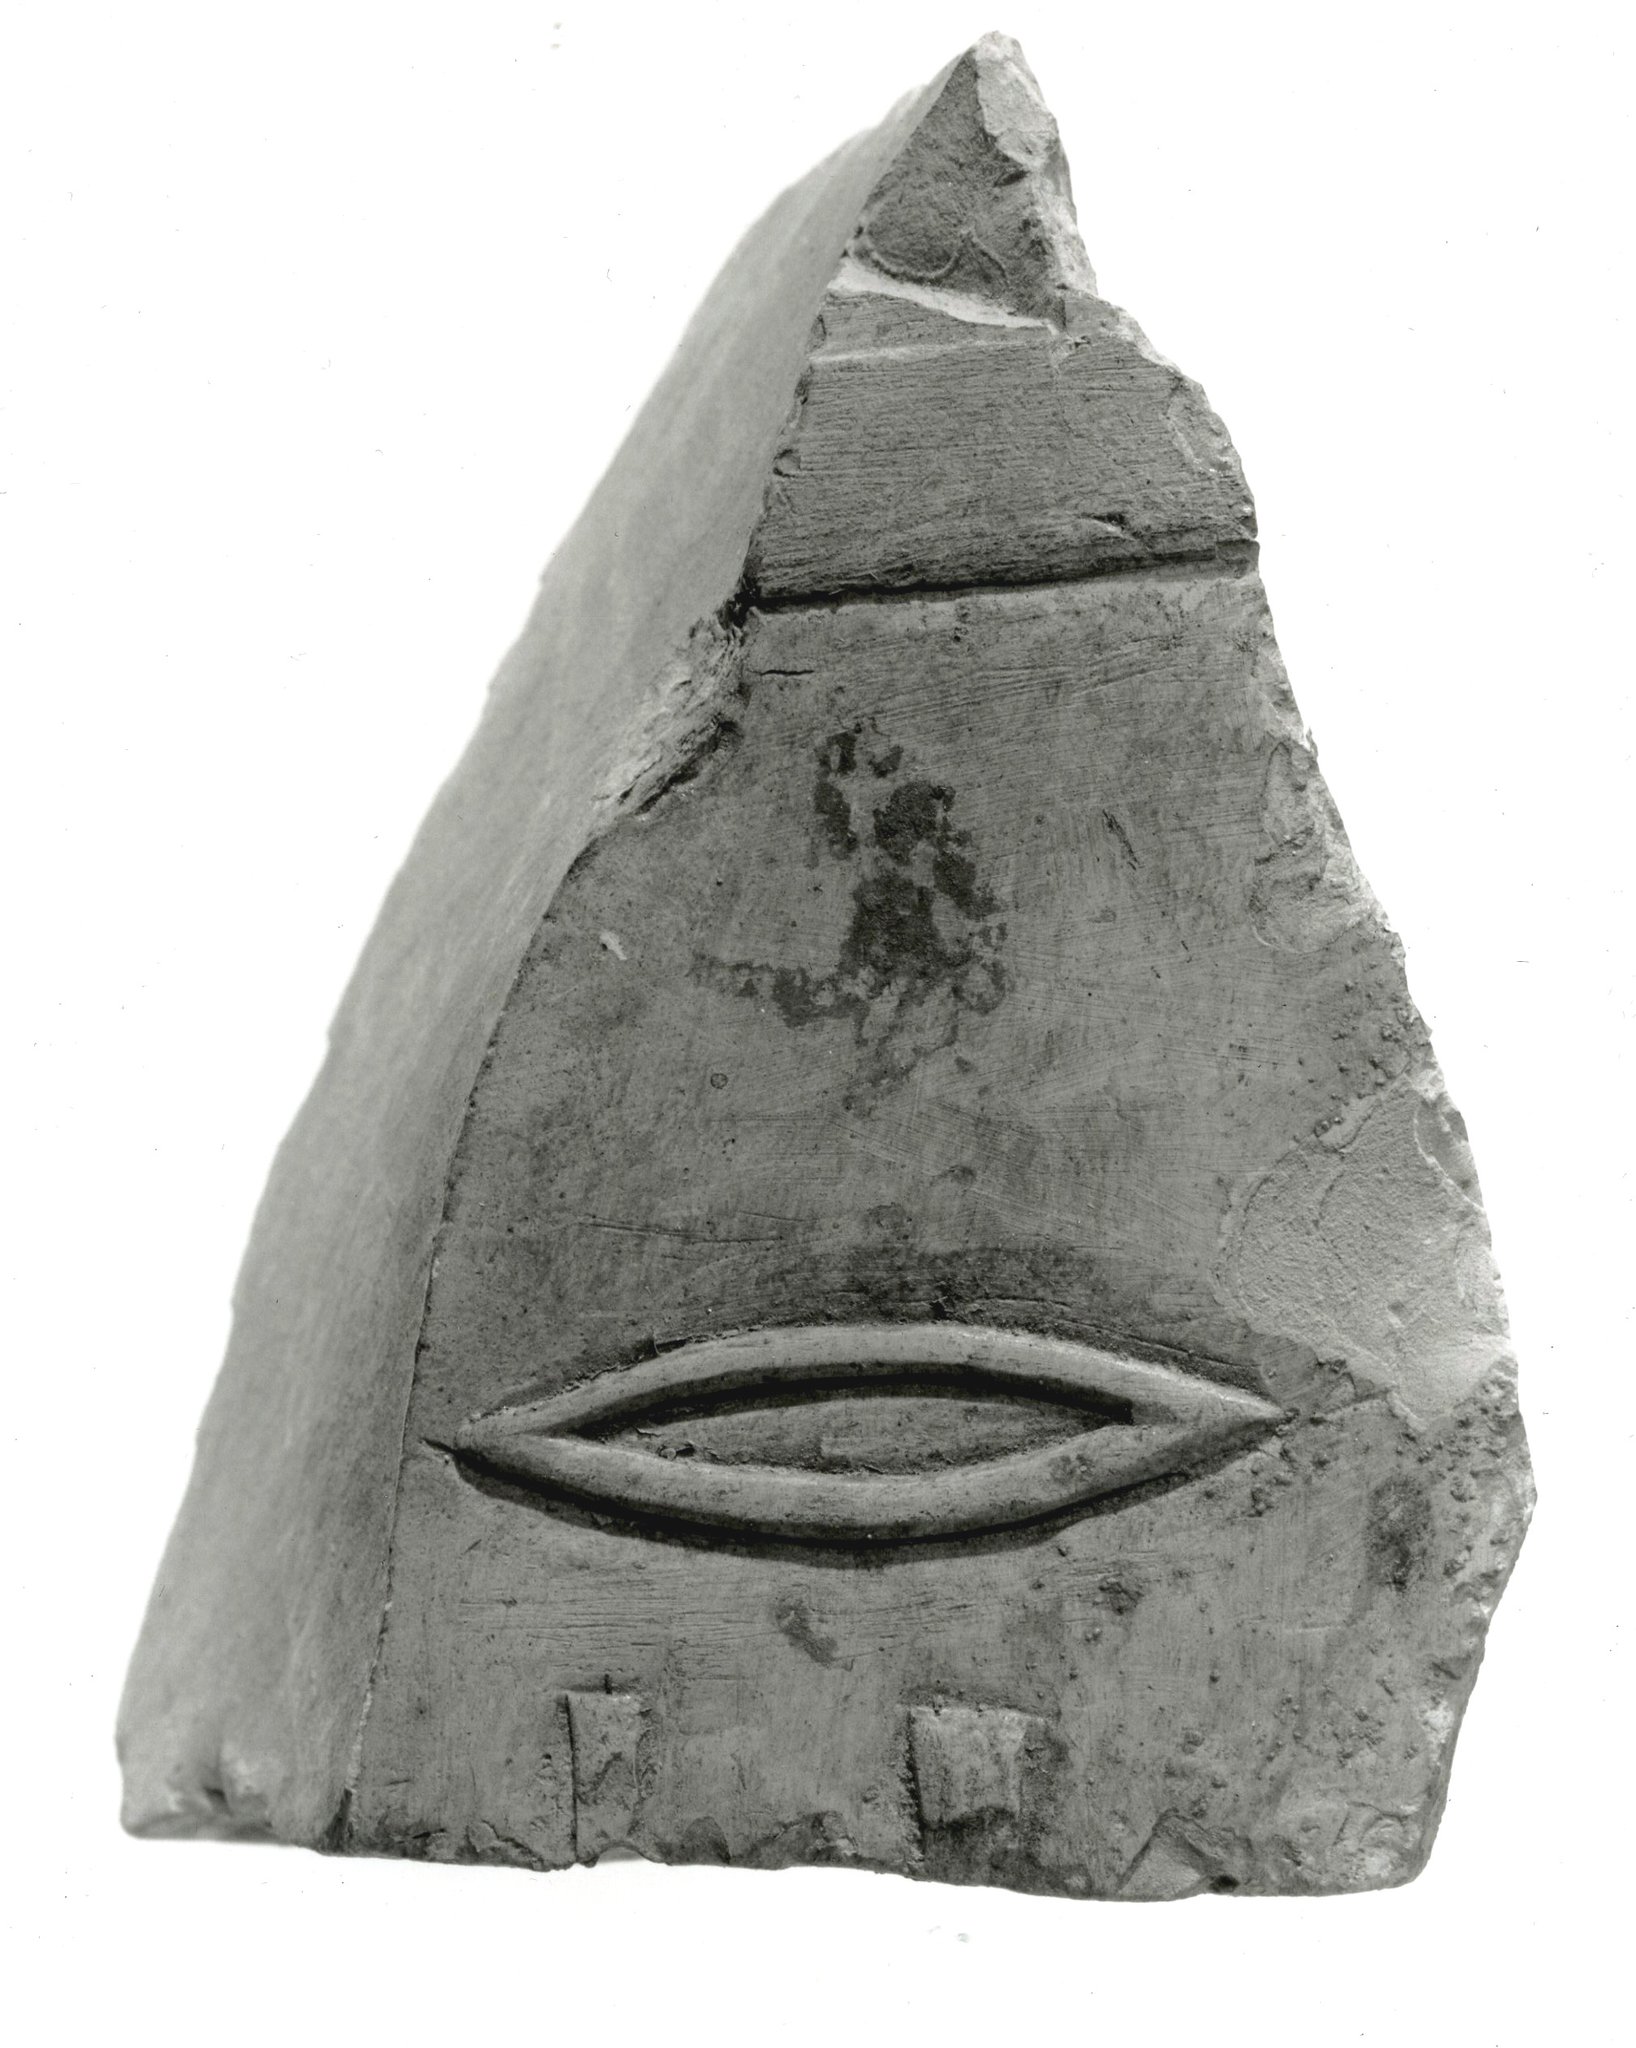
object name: relief, tomb of nespekashuty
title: Raised relief fragment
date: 664-610 BCE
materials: limestone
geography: egypt